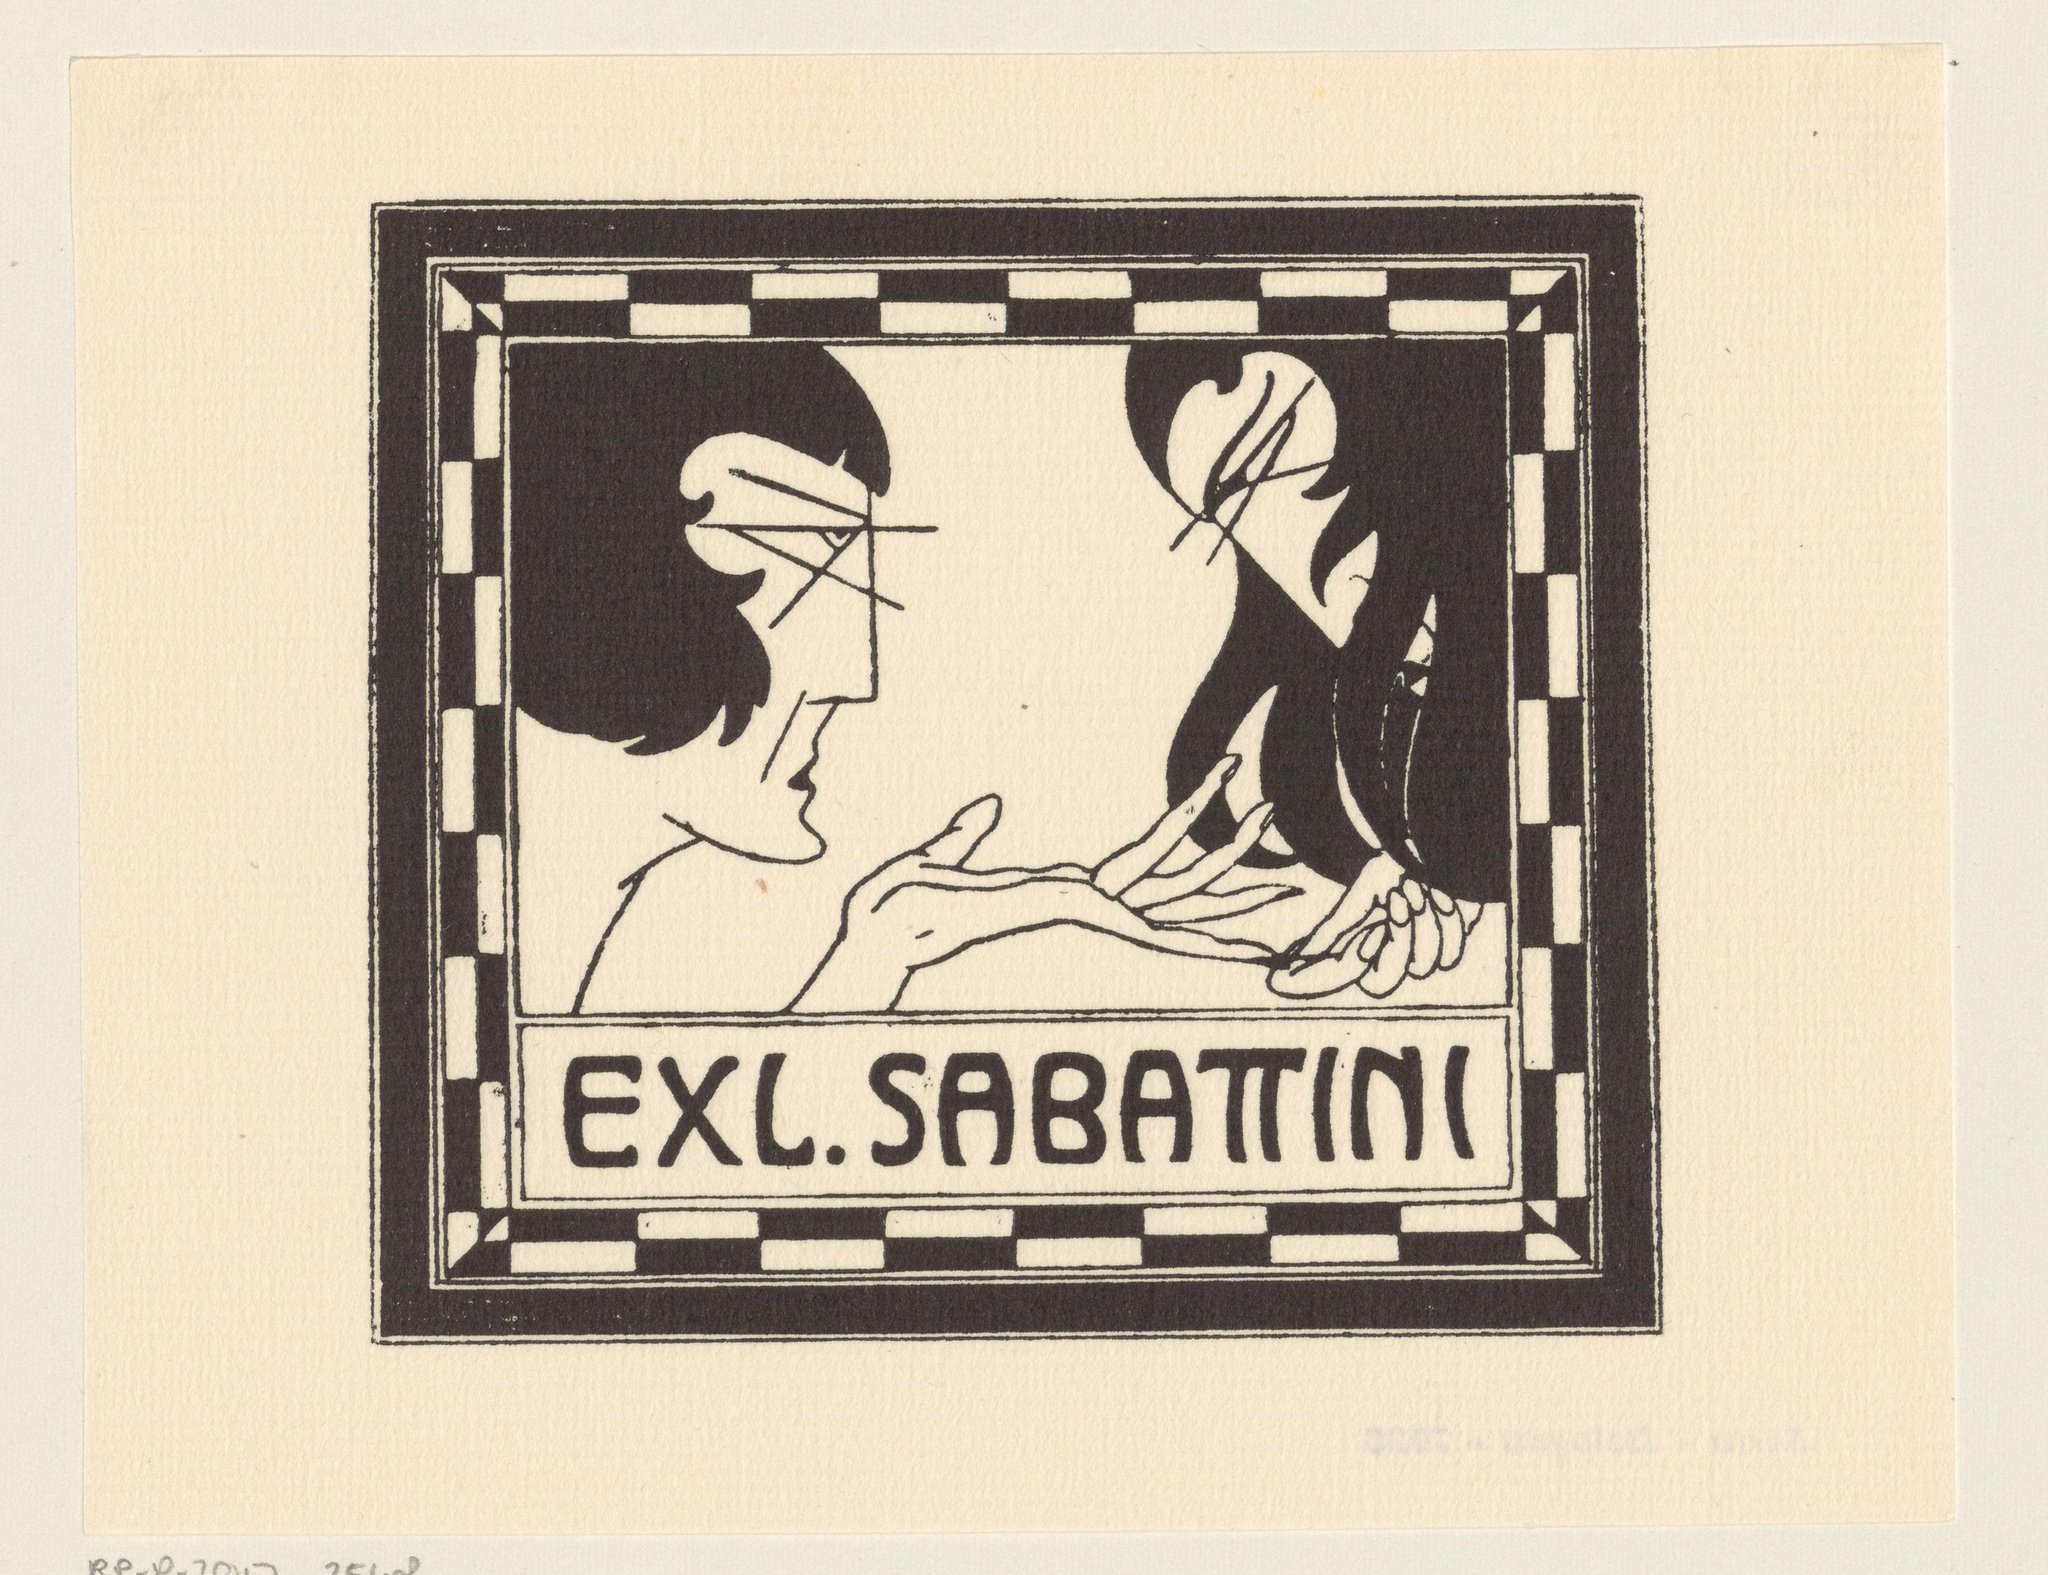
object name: bookplate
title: Ex libris van Sabattini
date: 1920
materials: paper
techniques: printing block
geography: italy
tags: gino sabattini, head (human), hand, head (human) - aa - female human figure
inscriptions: workshop stamp: ‘Serra - Bologna - 1920’